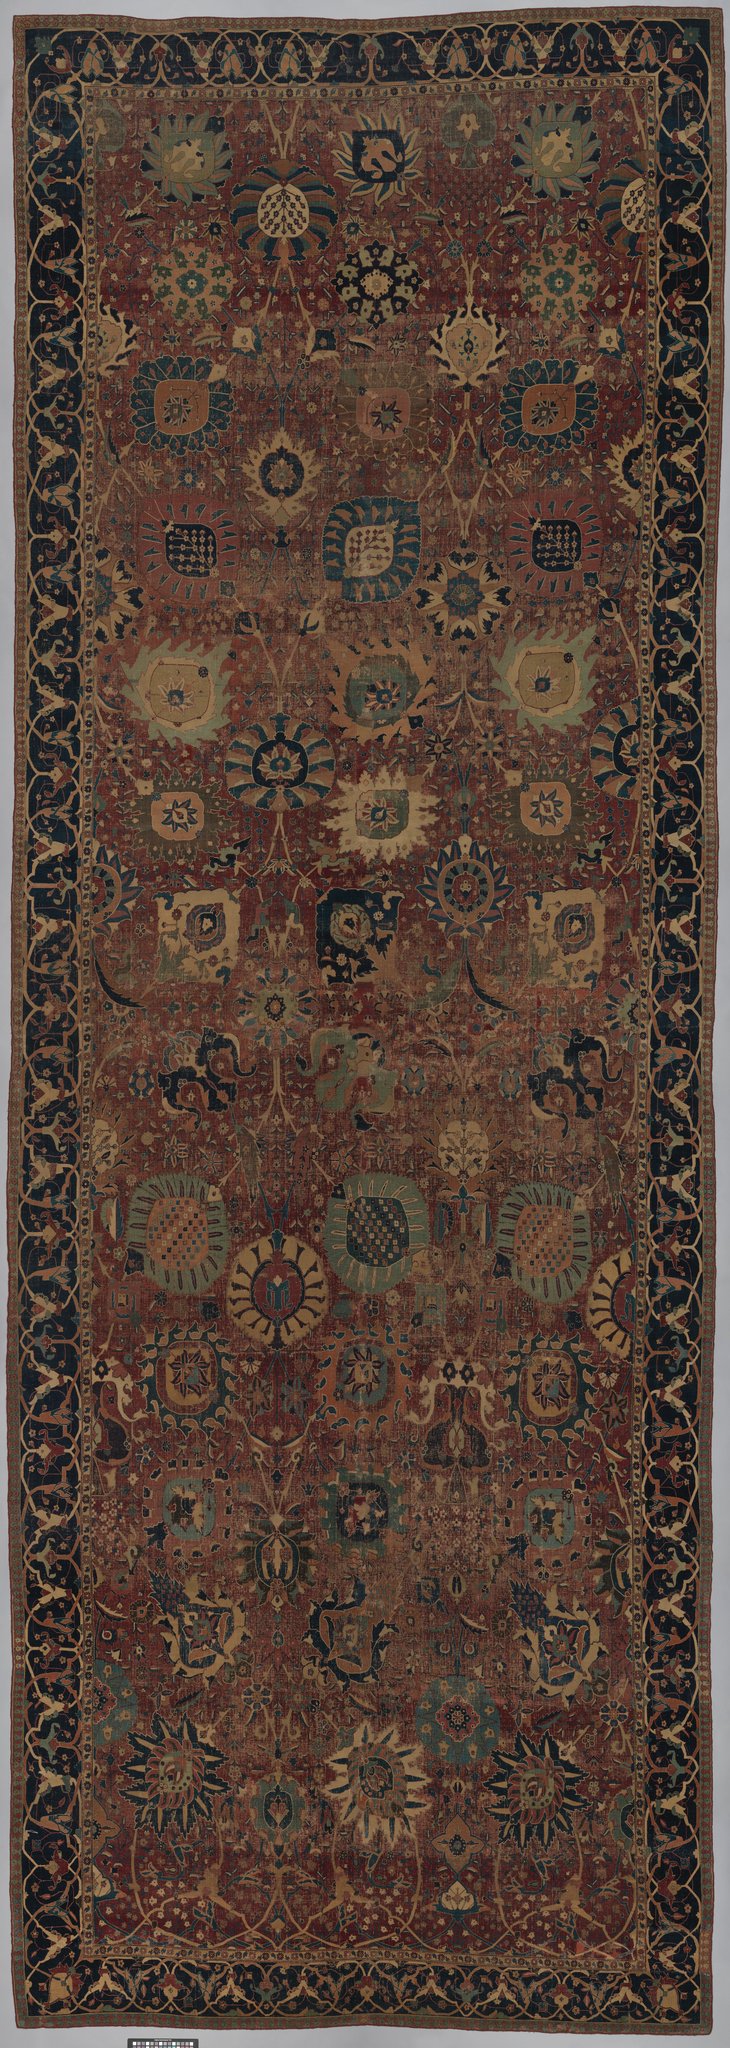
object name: carpet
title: Vase Carpet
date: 1567-1633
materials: cotton, silk, wool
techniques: asymmetrically knotted pile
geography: iran